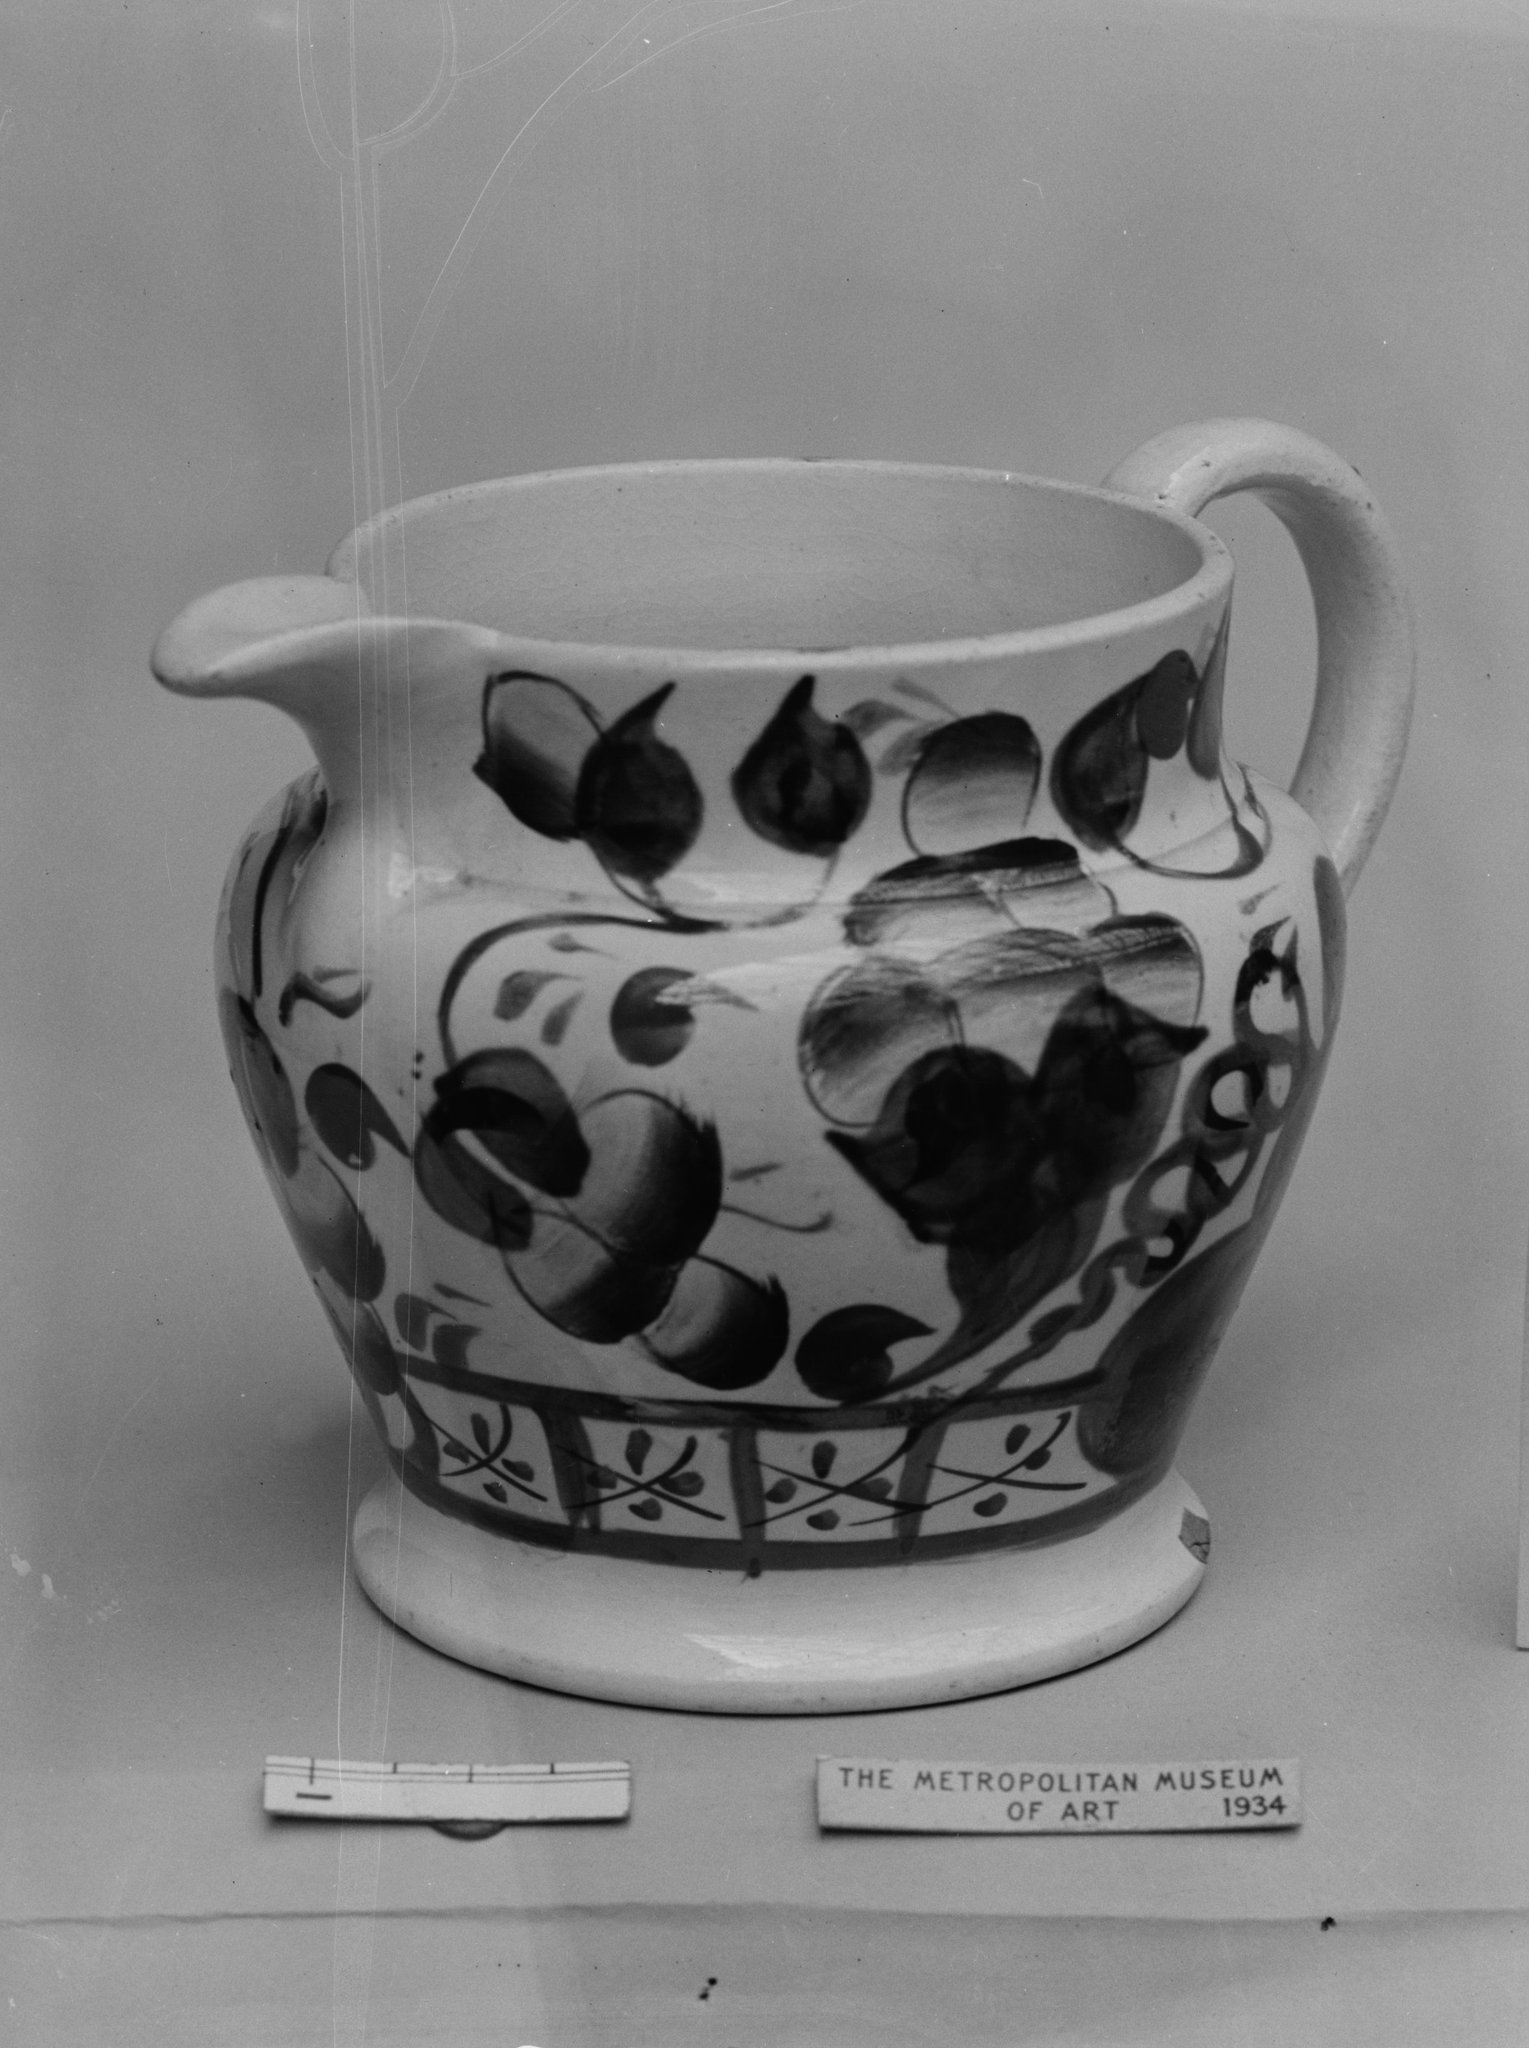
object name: cream pitcher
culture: british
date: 1825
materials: earthenware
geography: england